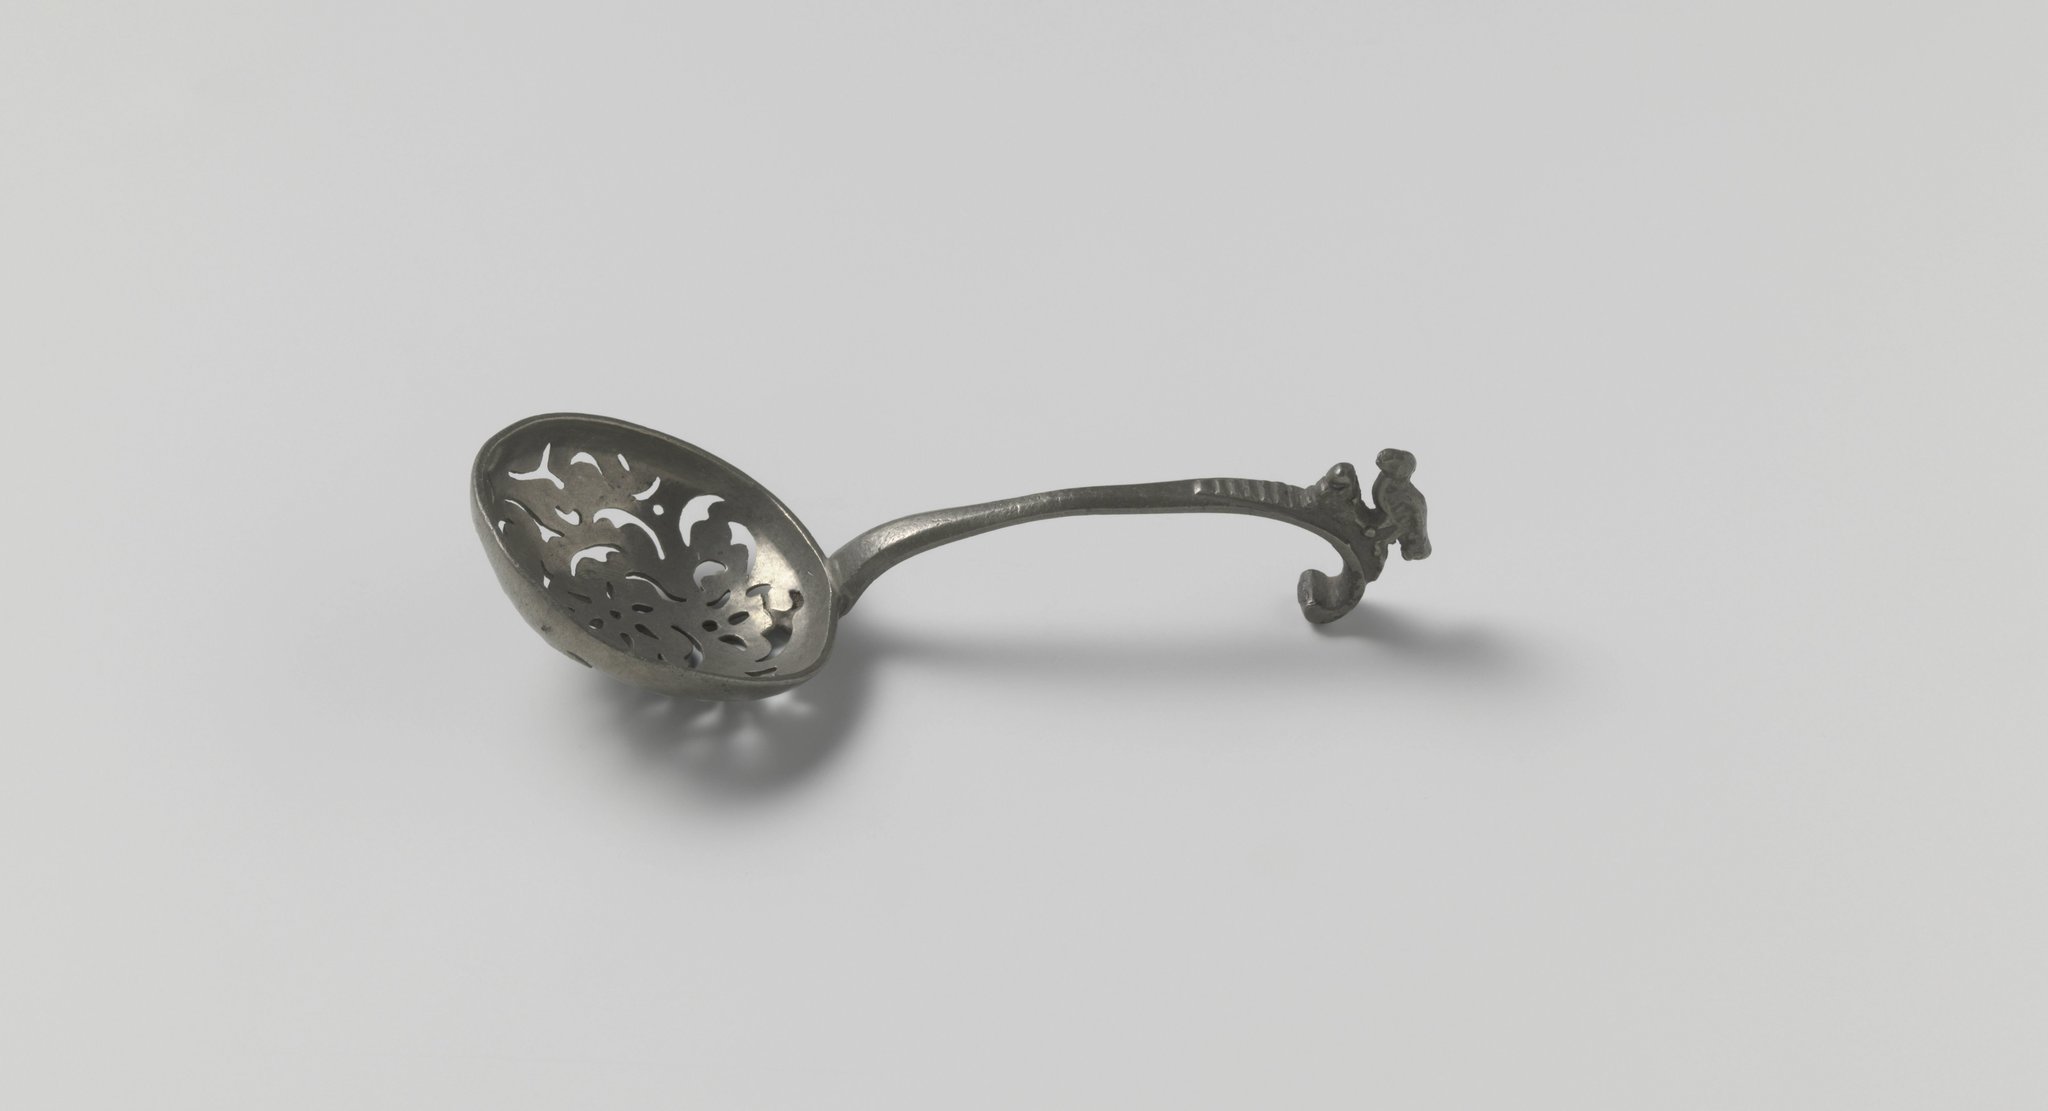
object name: suikerlepel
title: Suikerlepel van tin met vogel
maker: Anonymous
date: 1700-1800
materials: tin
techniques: casting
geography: western europe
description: Suikerlepel van tin. De steel is aan het einde gekruld en gedecoreerd met een opstaande vogel. De ronde bak is opengewerkt met een siermotief.